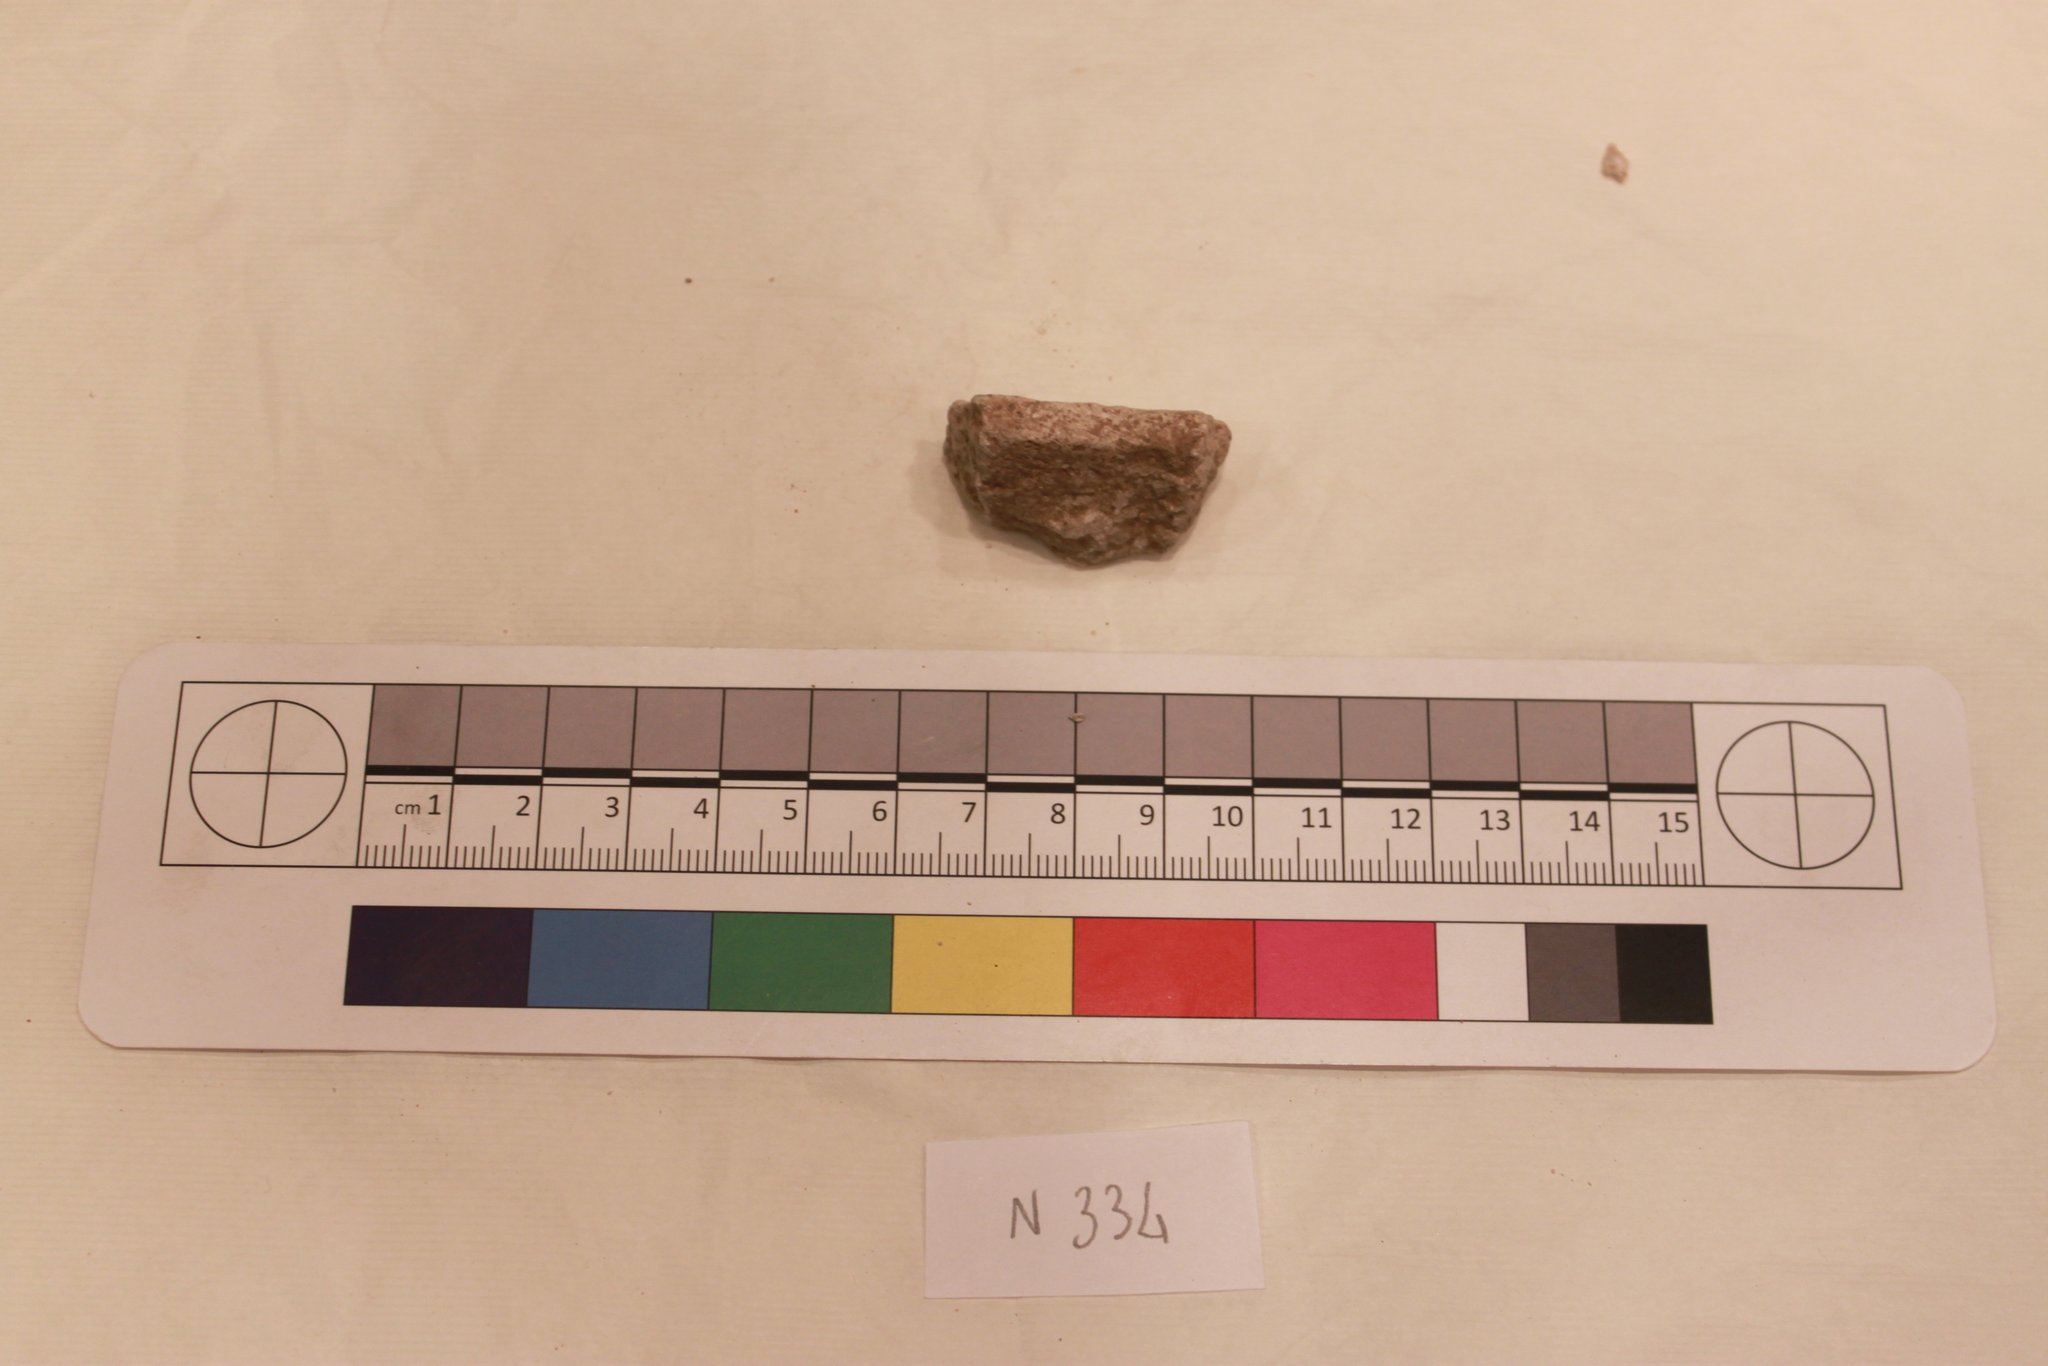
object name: fragment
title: Stucco Fragment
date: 701-1200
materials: plaster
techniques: carving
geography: iran